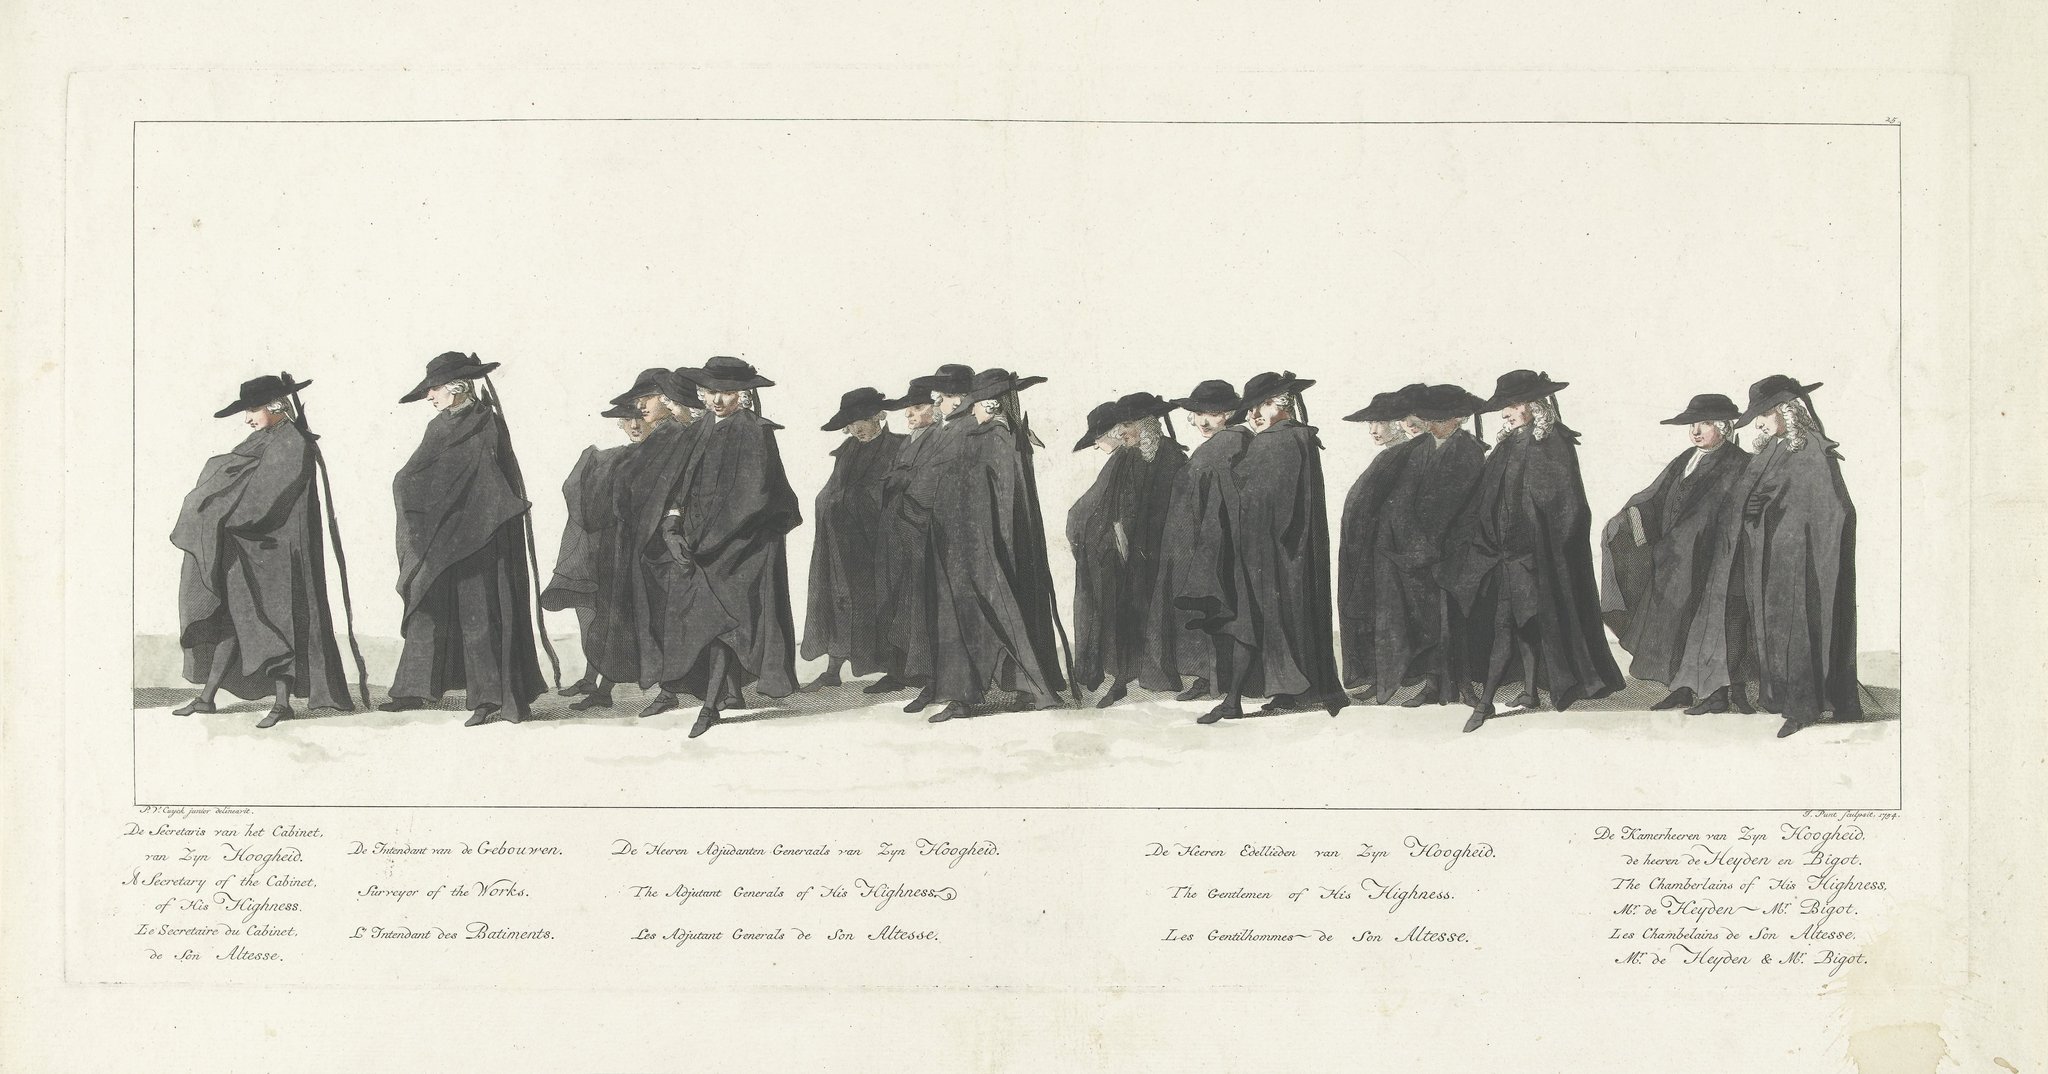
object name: print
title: Lijkstatie van Willem IV, 1752, plaat 25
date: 1754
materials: paper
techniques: engraving, etching, hand coloring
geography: northern netherlands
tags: the hague, willem iv (prins van oranje-nassau), cortege, funeral procession, royal household; courtiers, retinue, train, delft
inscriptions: collector's mark: Lugt 2228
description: Leden van de stadhouderlijke huishouding en een groep edelen. In de marge het onderschrift in Nederlands, Frans en Engels. Onderdeel van een serie van 41 platen van de begrafenisstoet van stadhouder Willem IV te Delft op 4 februari 1752. Genummerd rechtsboven: 25.